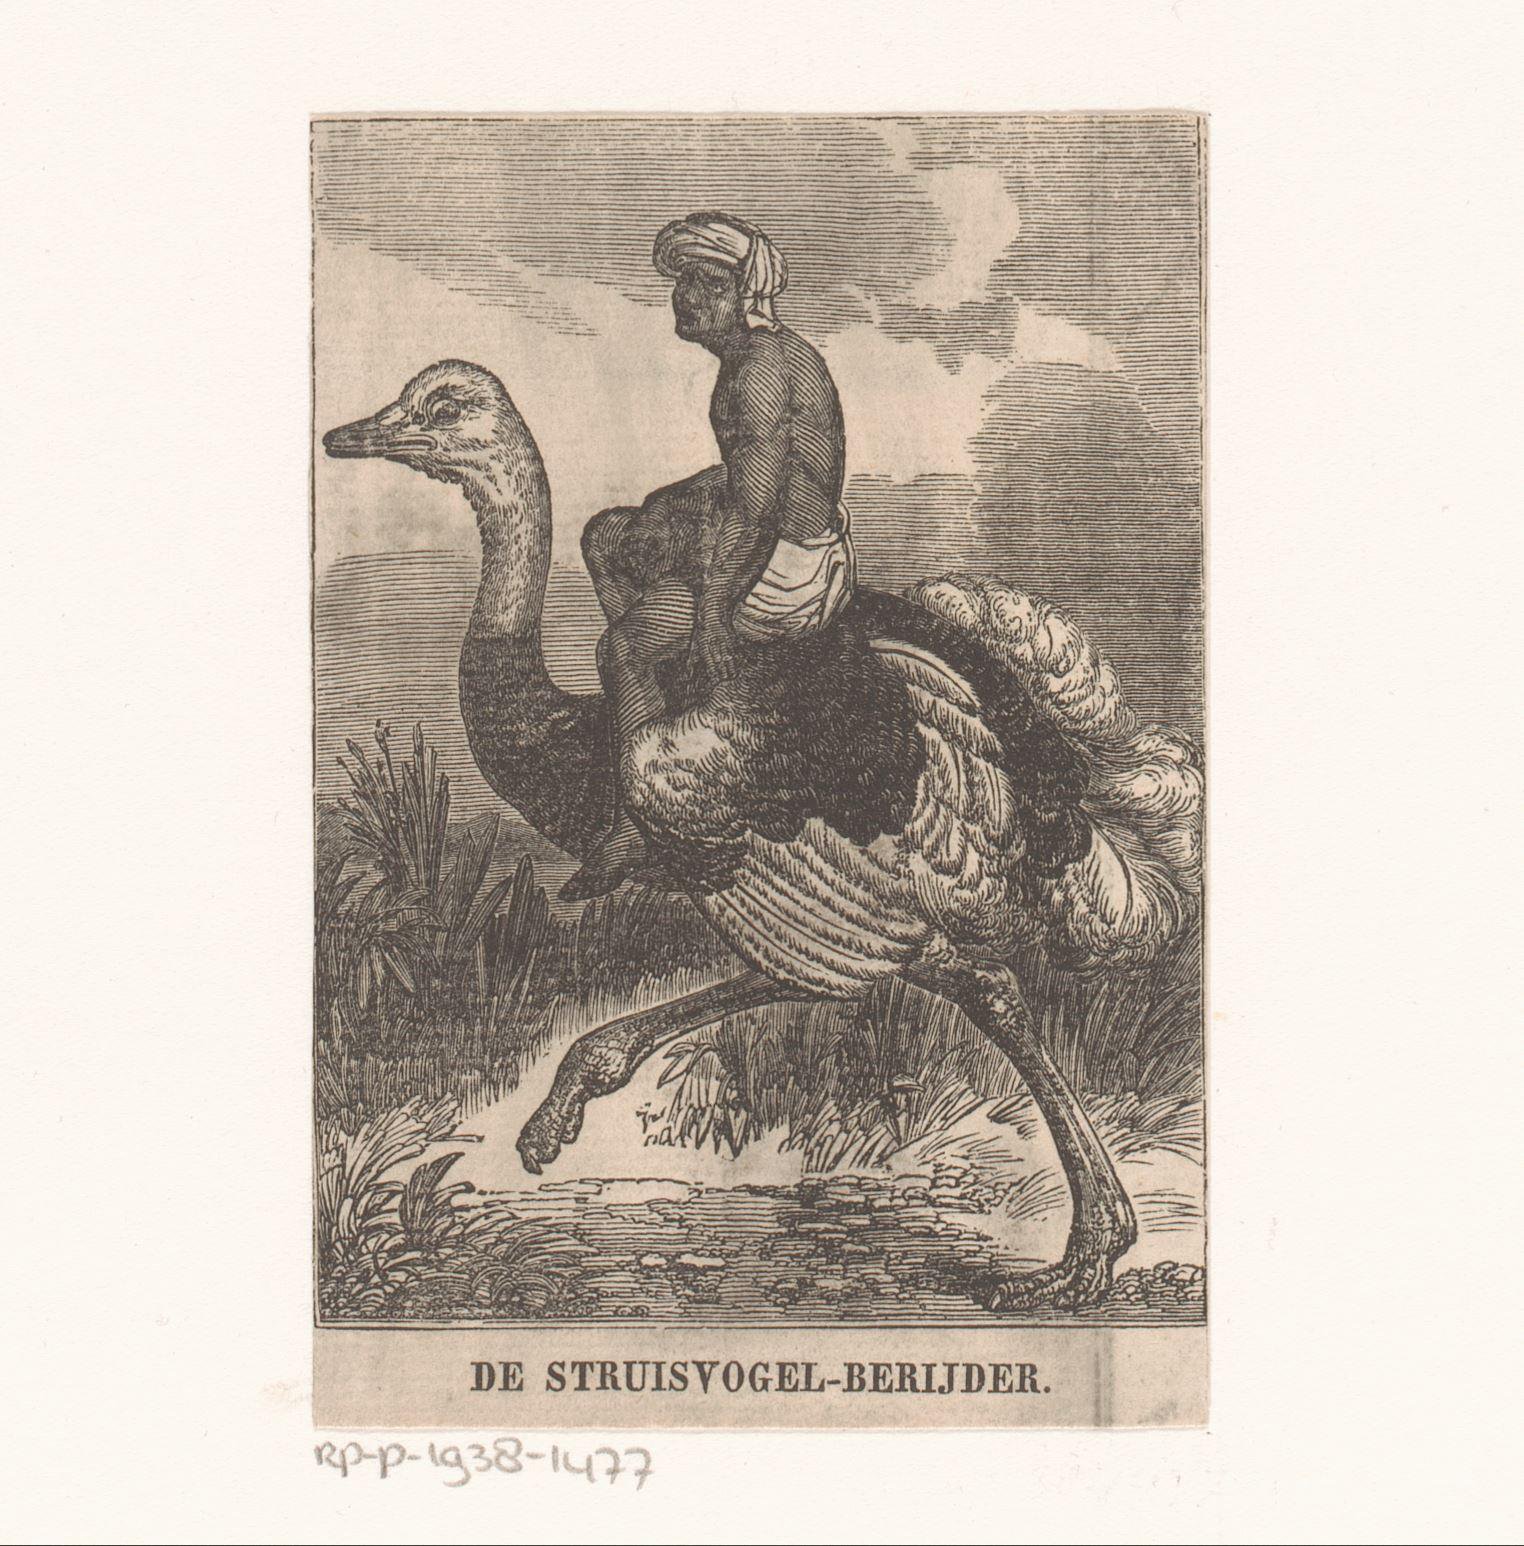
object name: print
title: De struisvogel-berijder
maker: Anonymous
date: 1800-1899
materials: paper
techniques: engraving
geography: netherlands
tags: walker and runner birds: ostrich, head-gear: turban, human races, peoples and nationalities (other than prehistoric or extinct)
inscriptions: collector's mark: Lugt 2228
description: Donkere man met een tulband rijdend op een struisvogel.